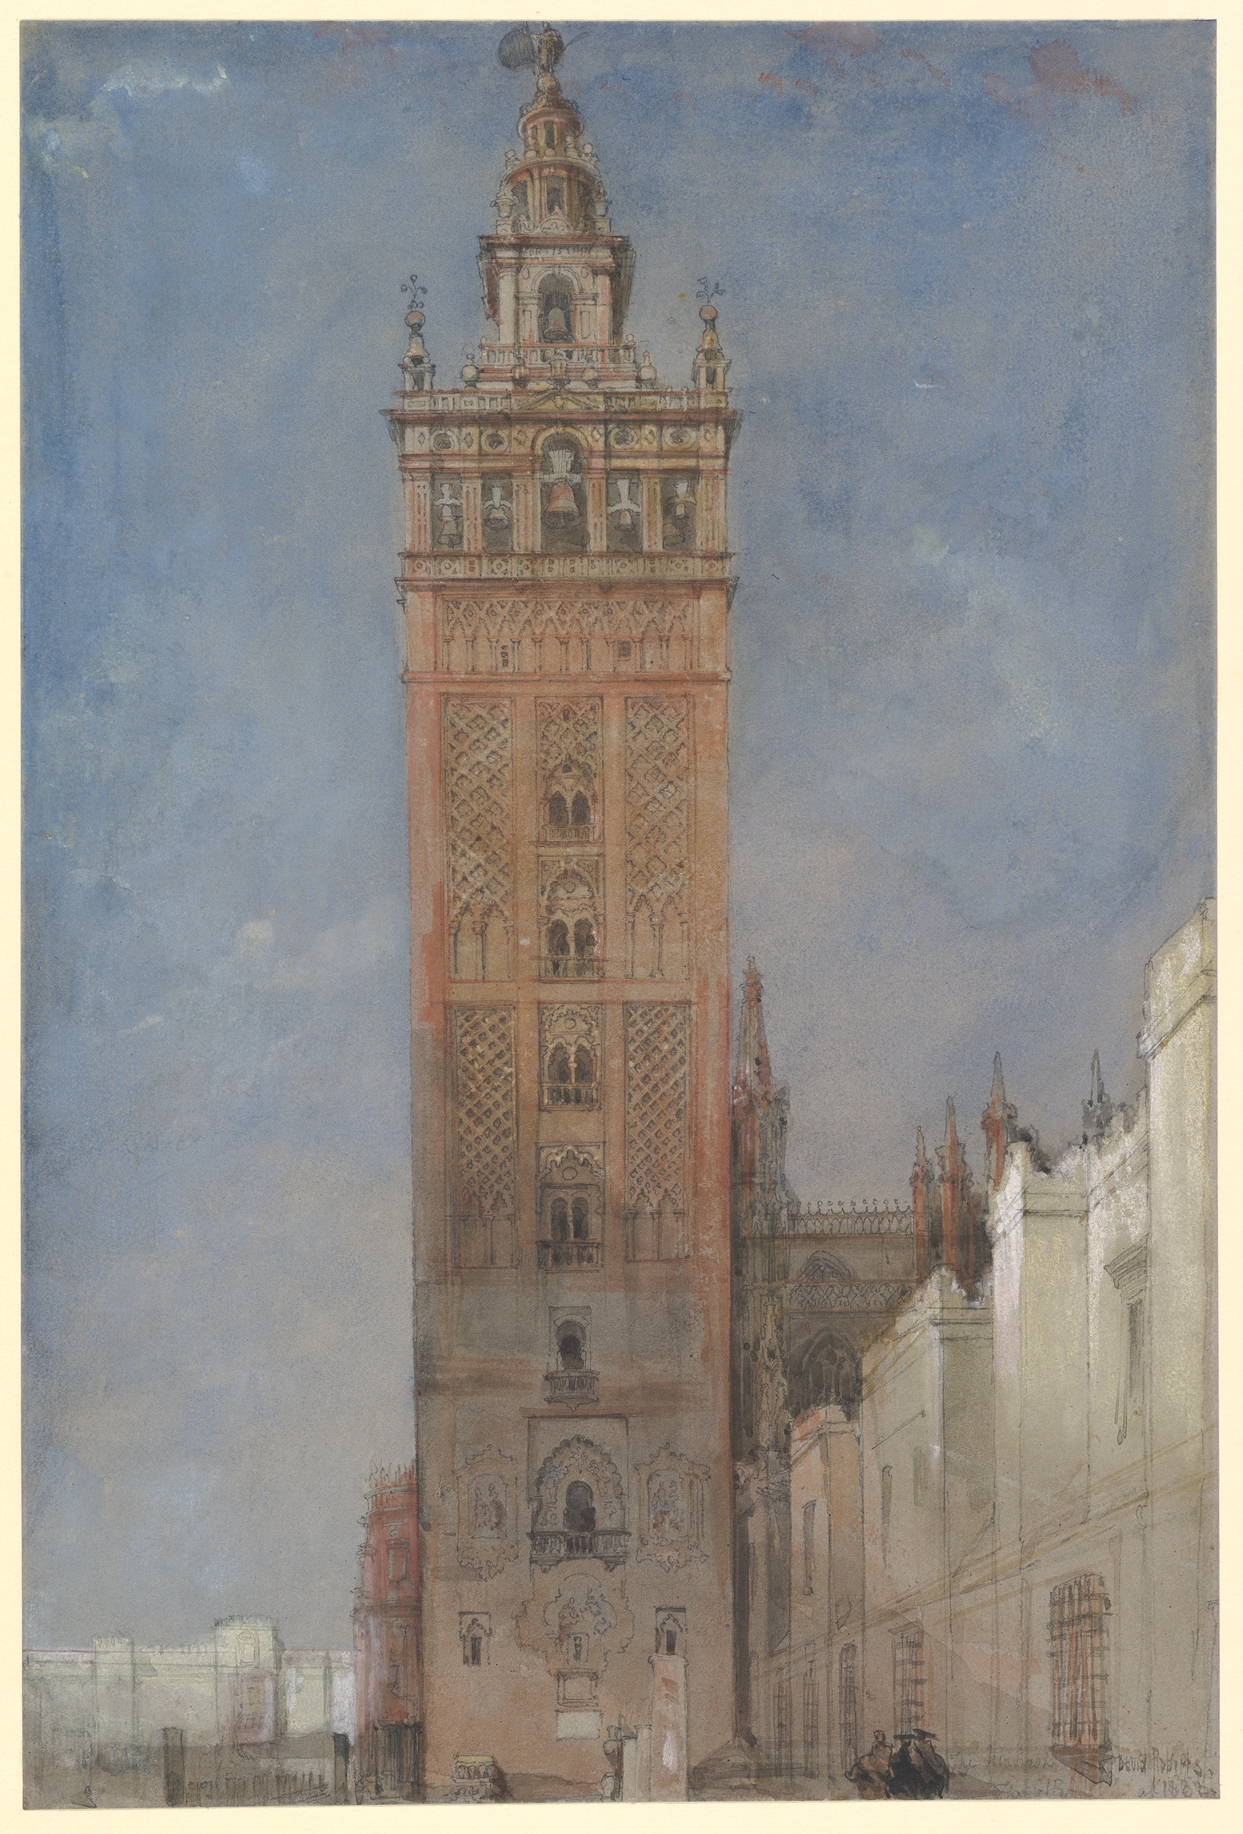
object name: drawing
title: The Giralda, Seville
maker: david roberts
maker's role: artist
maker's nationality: british, scottish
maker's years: 1796-1864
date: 1833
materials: gouache, graphite, paper, watercolor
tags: towers